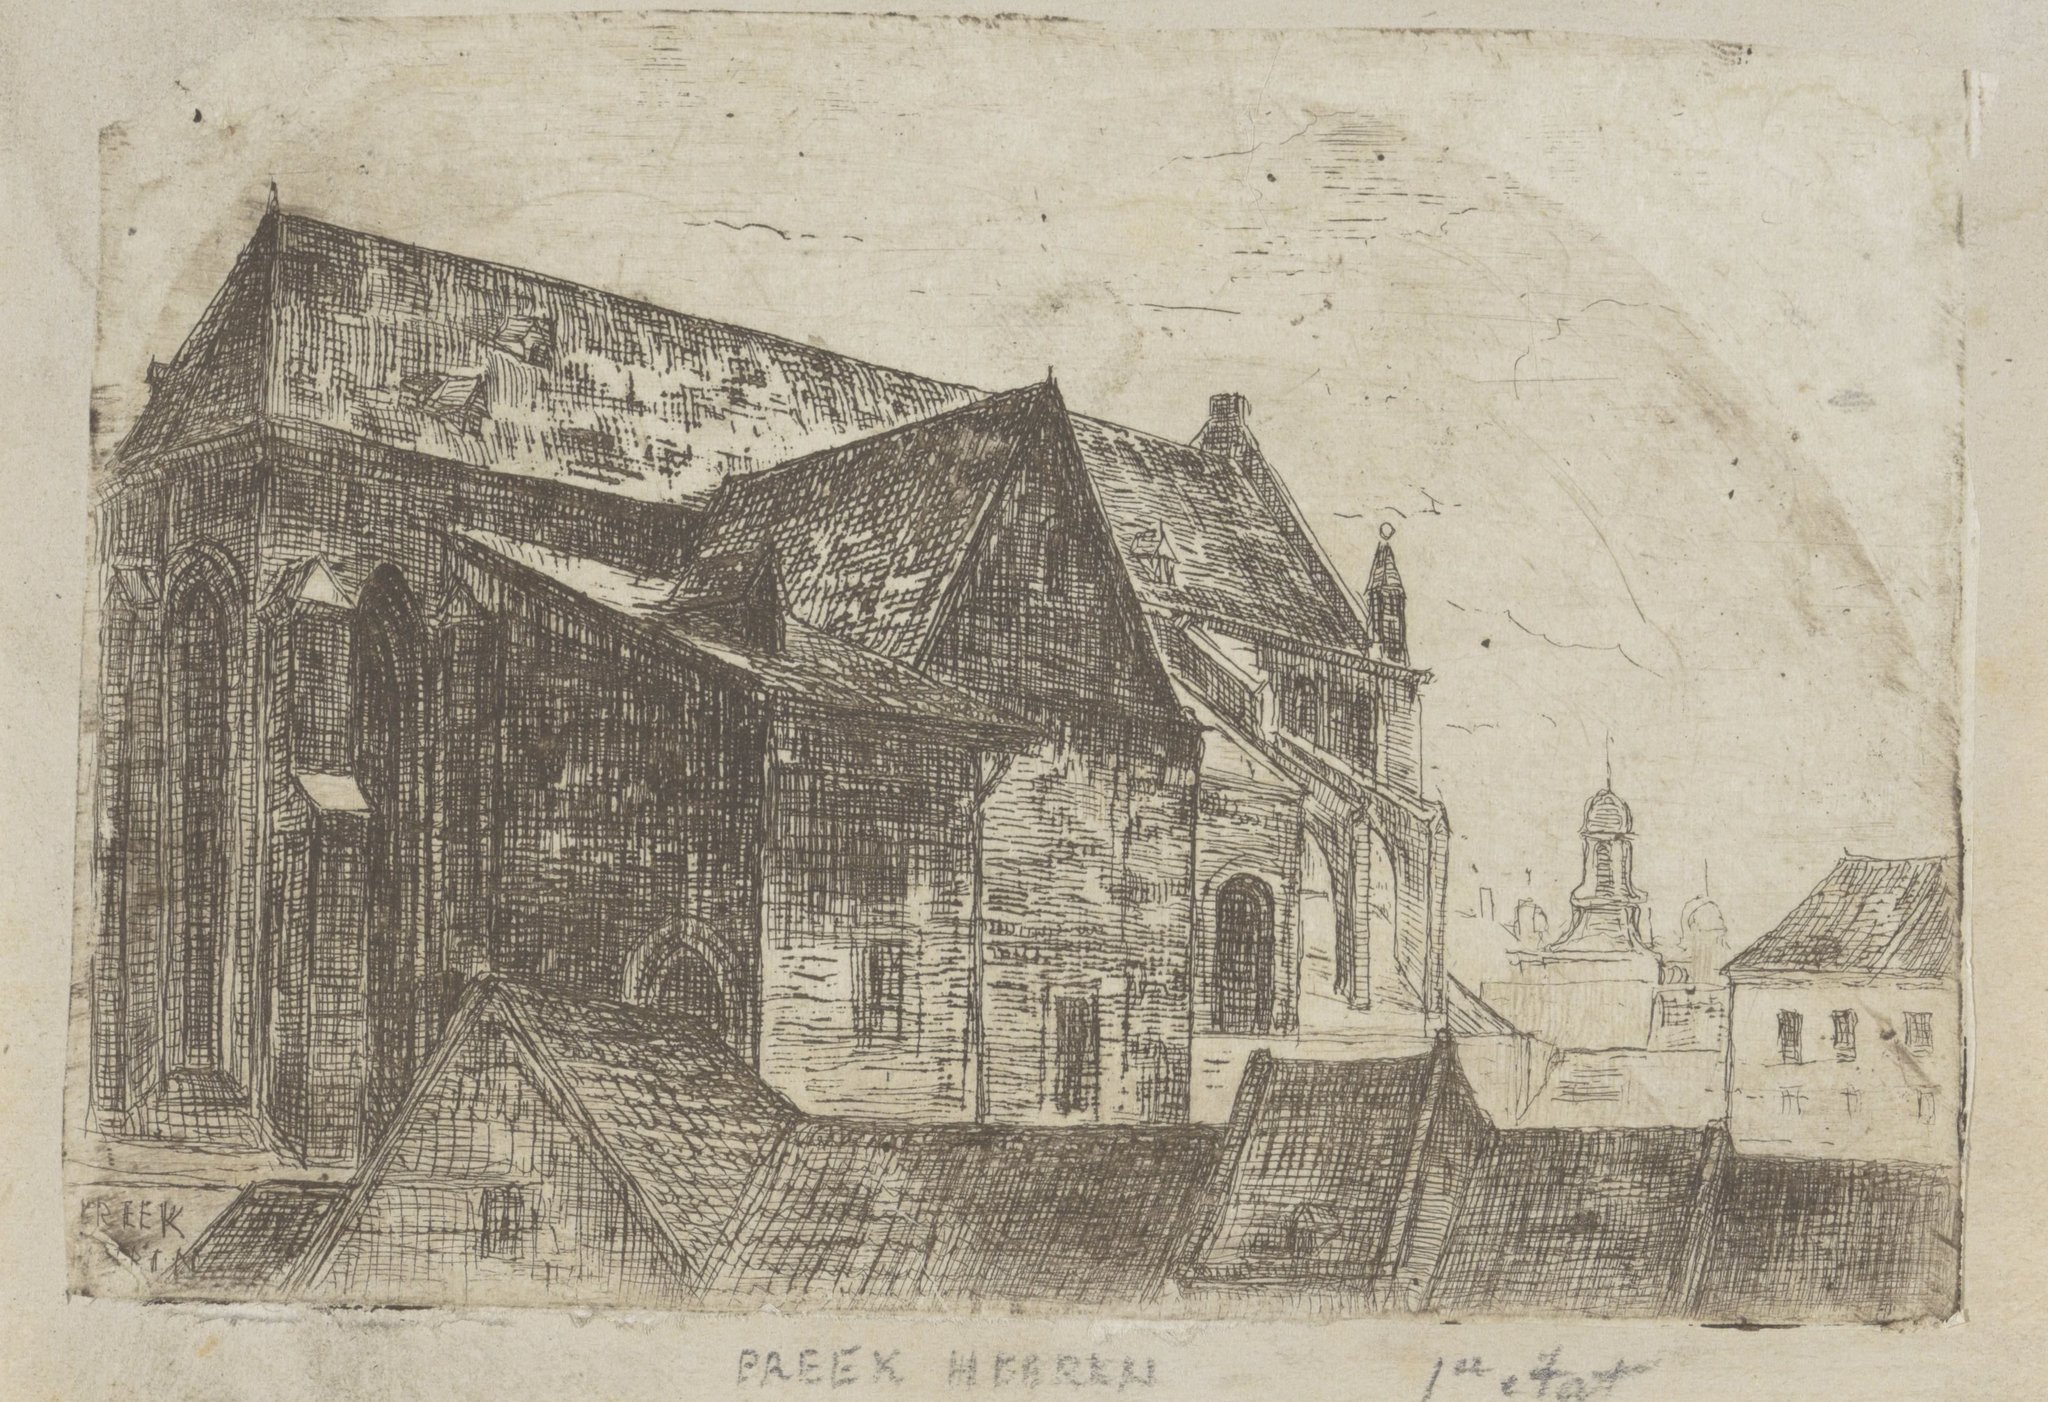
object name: print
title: Preek Heeren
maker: alexander schaepkens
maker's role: draughtsman, print maker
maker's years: 1815-1899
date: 1830-1899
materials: paper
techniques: etching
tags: church (exterior), maastricht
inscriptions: collector's mark: Lugt 2228